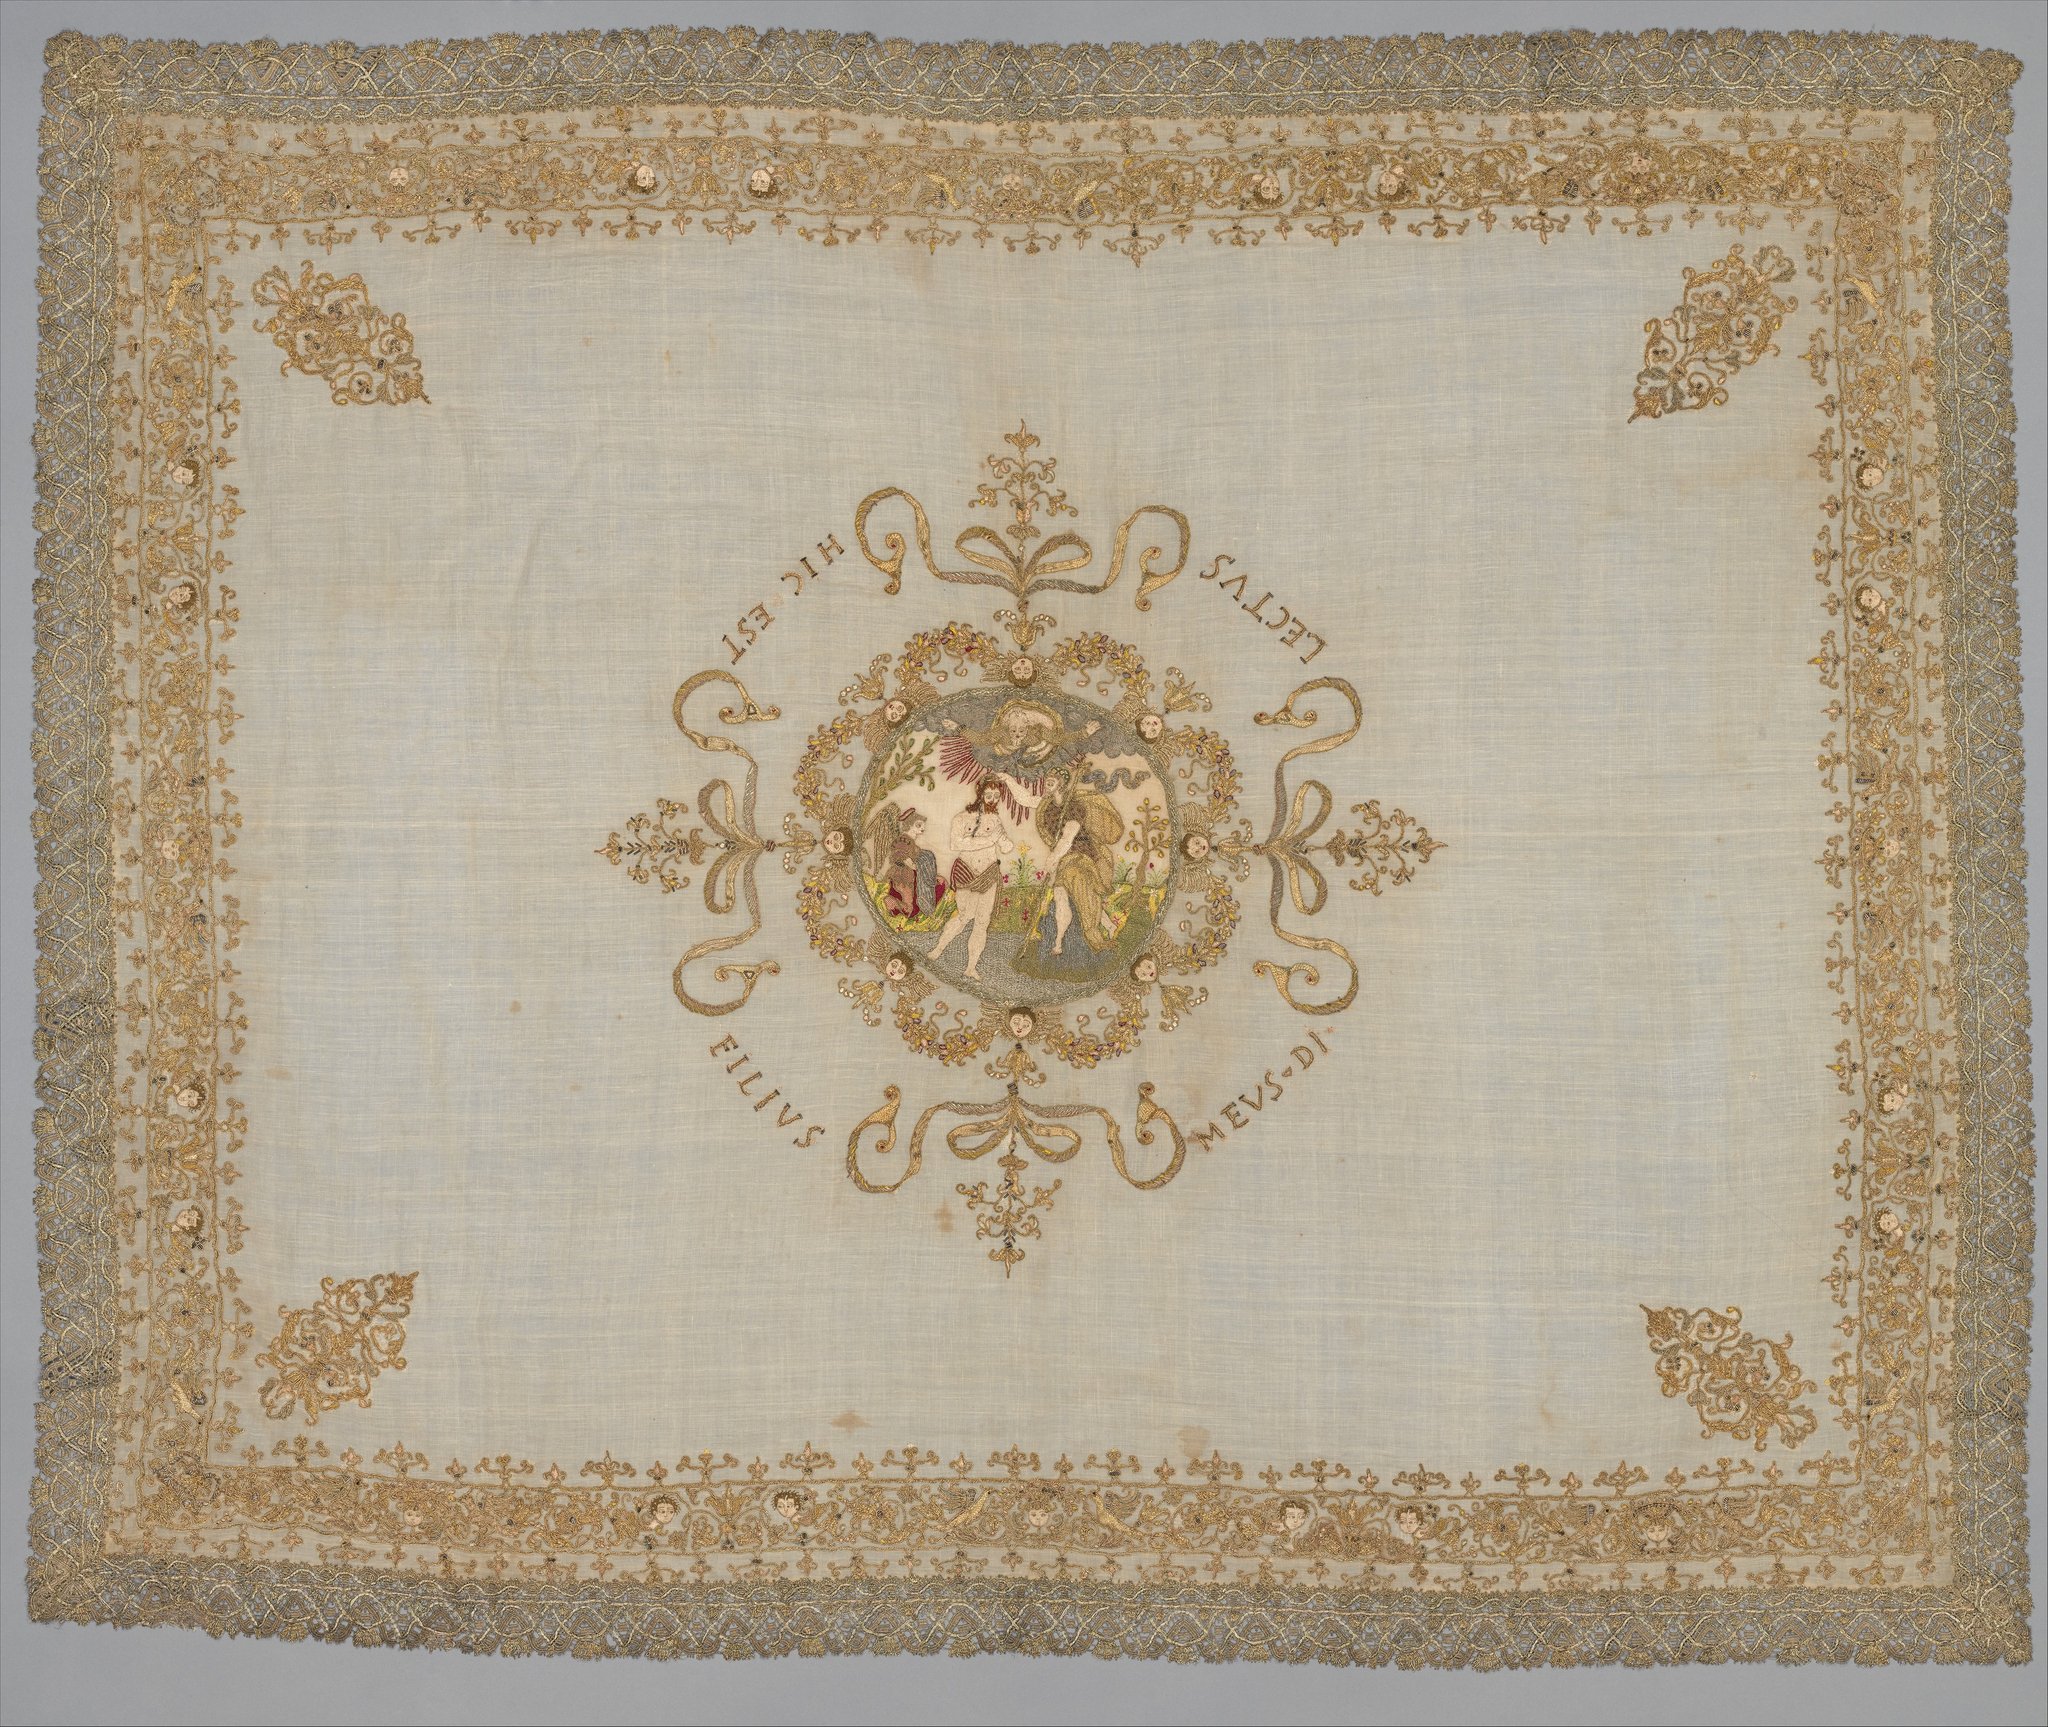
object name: chalice cover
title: Chalice veil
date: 1567-1600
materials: linen, metal thread, silk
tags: angels,christ,saint john the baptist